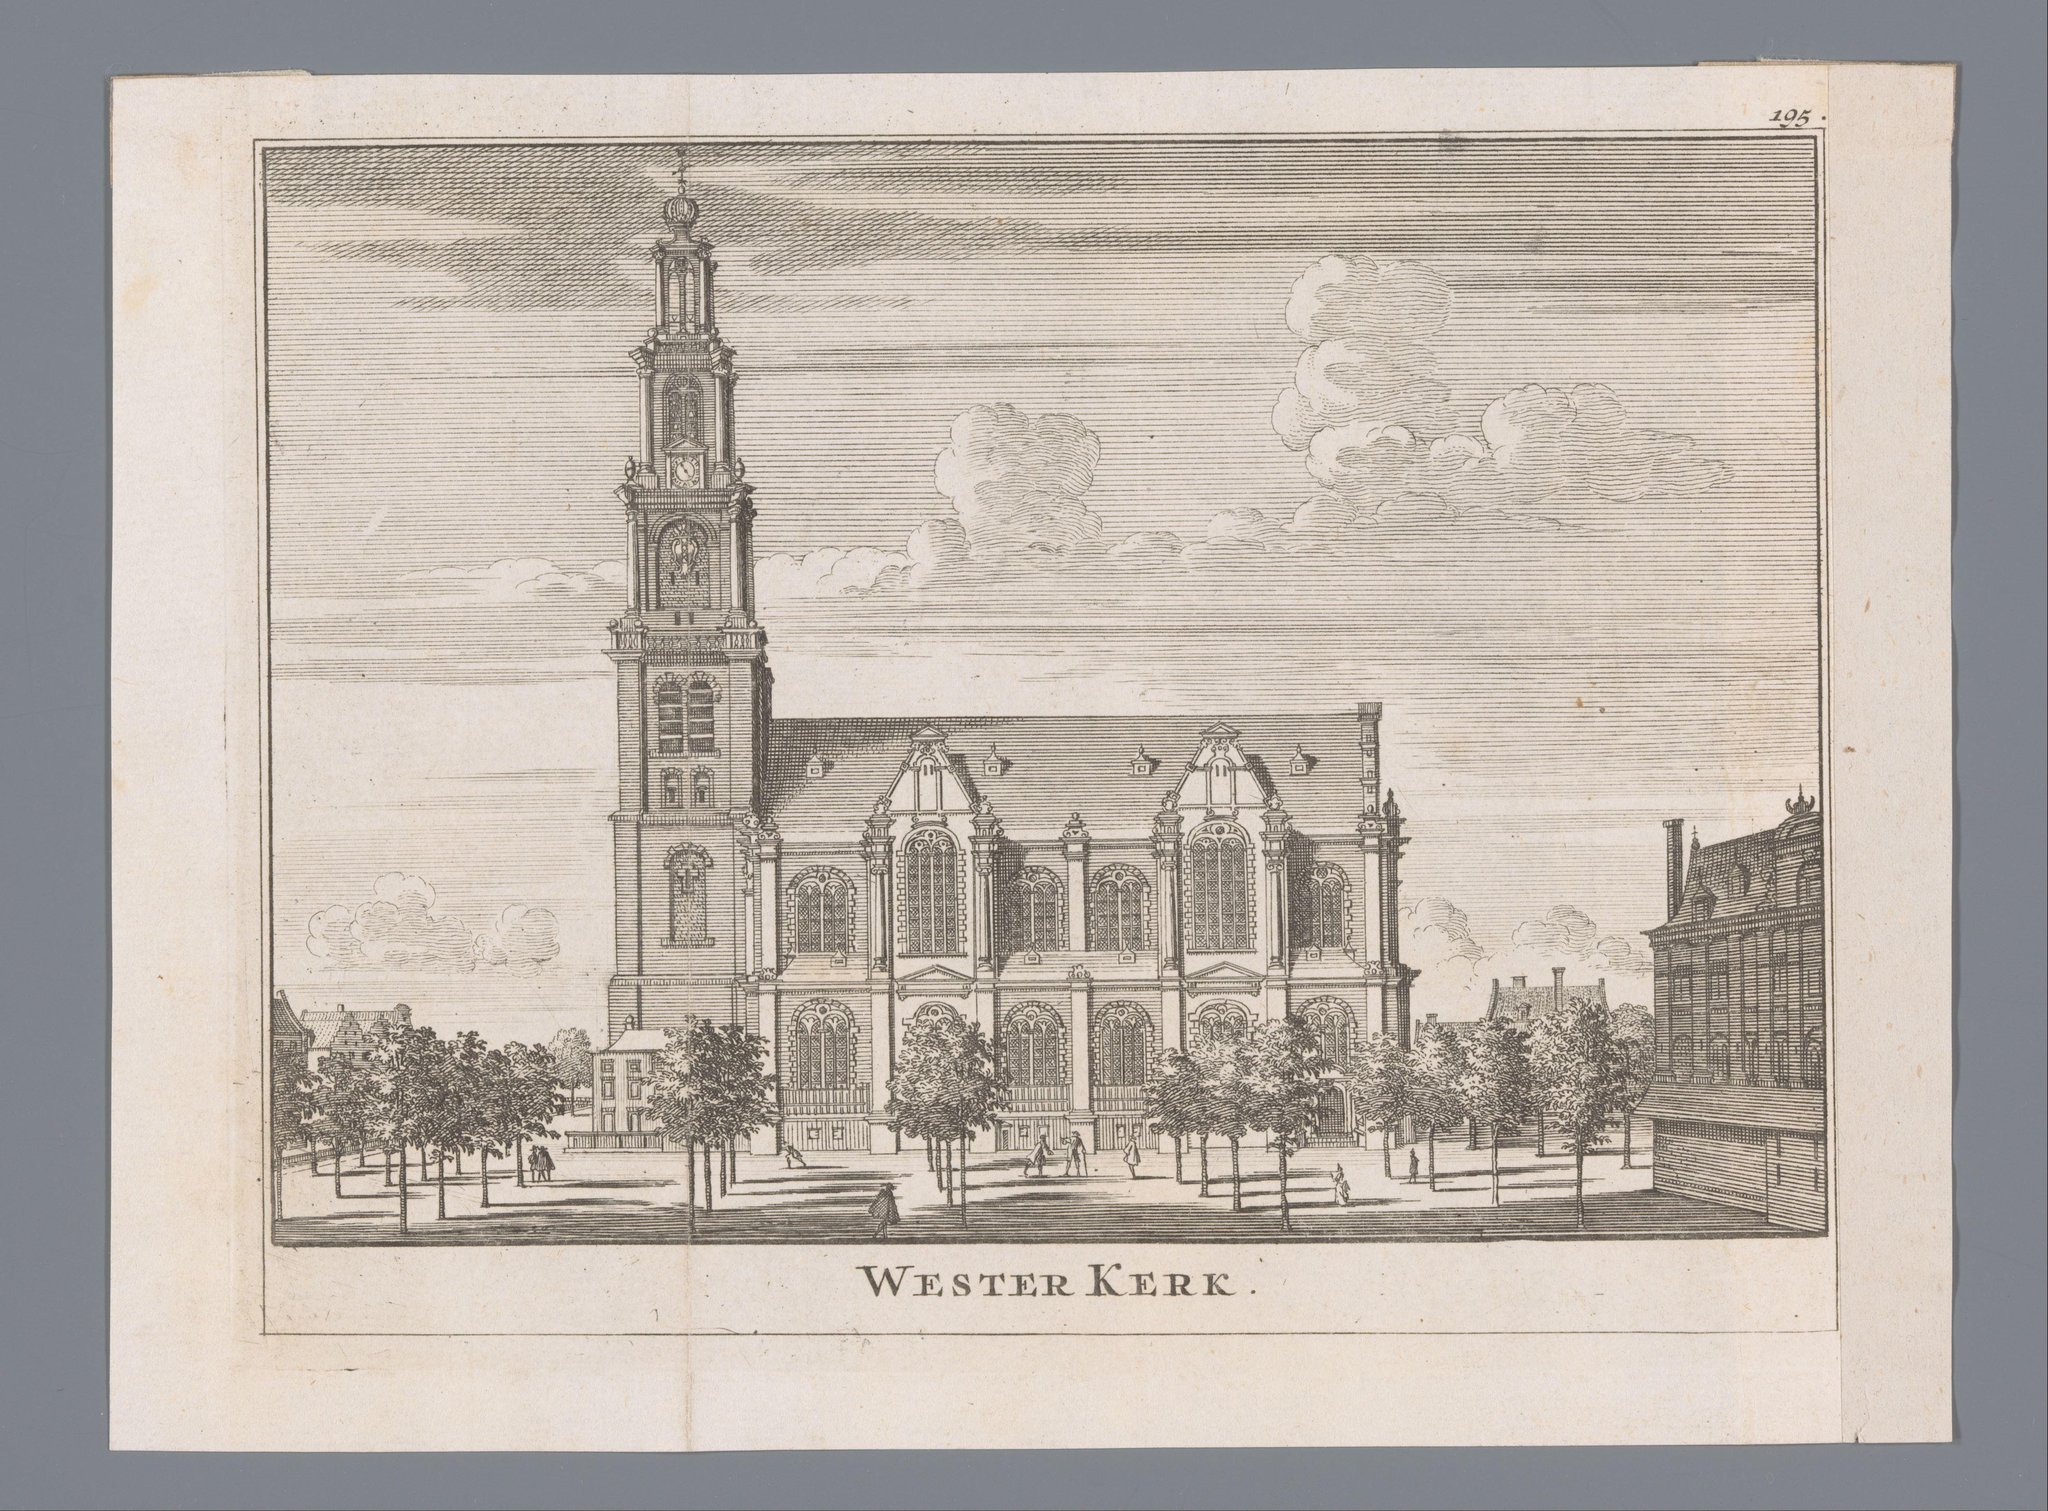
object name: print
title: Wester Kerk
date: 1751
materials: paper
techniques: etching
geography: amsterdam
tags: protestant churches and denominations, exterior ~ representation of a building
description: Prent uit: Hoorn, Nicolaas ten. Wegwyzer of korte beschryvinge der stad Amsterdam. Zynde eene Beknopte Verhandeling van derzelver eerste Opkomst, Vergrootingen en Tegenwoordigen Staat (…). Amsterdam: Pieter Meyer, 1751, p. 195. Prent eerder, met verschillende nummers, gebruikt in: Hoorn, Nicolaas ten. Wegwyzer door Amsterdam, Zynde eene beknopte verhandeling van desselfs eerste opkomst, vergrootingen, en teegenwoordigen staat (…). Amsterdam: Nicolaas ten Hoorn, 1713. En in: Hoorn, Nicolaas ten. Wegwyzer door Amsterdam, Zynde eene beknopte verhandeling van desselfs eerste opkomst, vergrootingen, en teegenwoordigen staat (…). Amsterdam: Nicolaas ten Hoorn, 1726. En in: Hoorn, Nicolaas ten. Wegwyzer, of korte beschryvinge Van de Stadt Amsterdam, Zynde eene beknopte Verhandeling van desselfs eerste opkomst, vergrootingen, en tegenwoordigen staat (…). Amsterdam: erven J. Ratelband & Co, 1737.